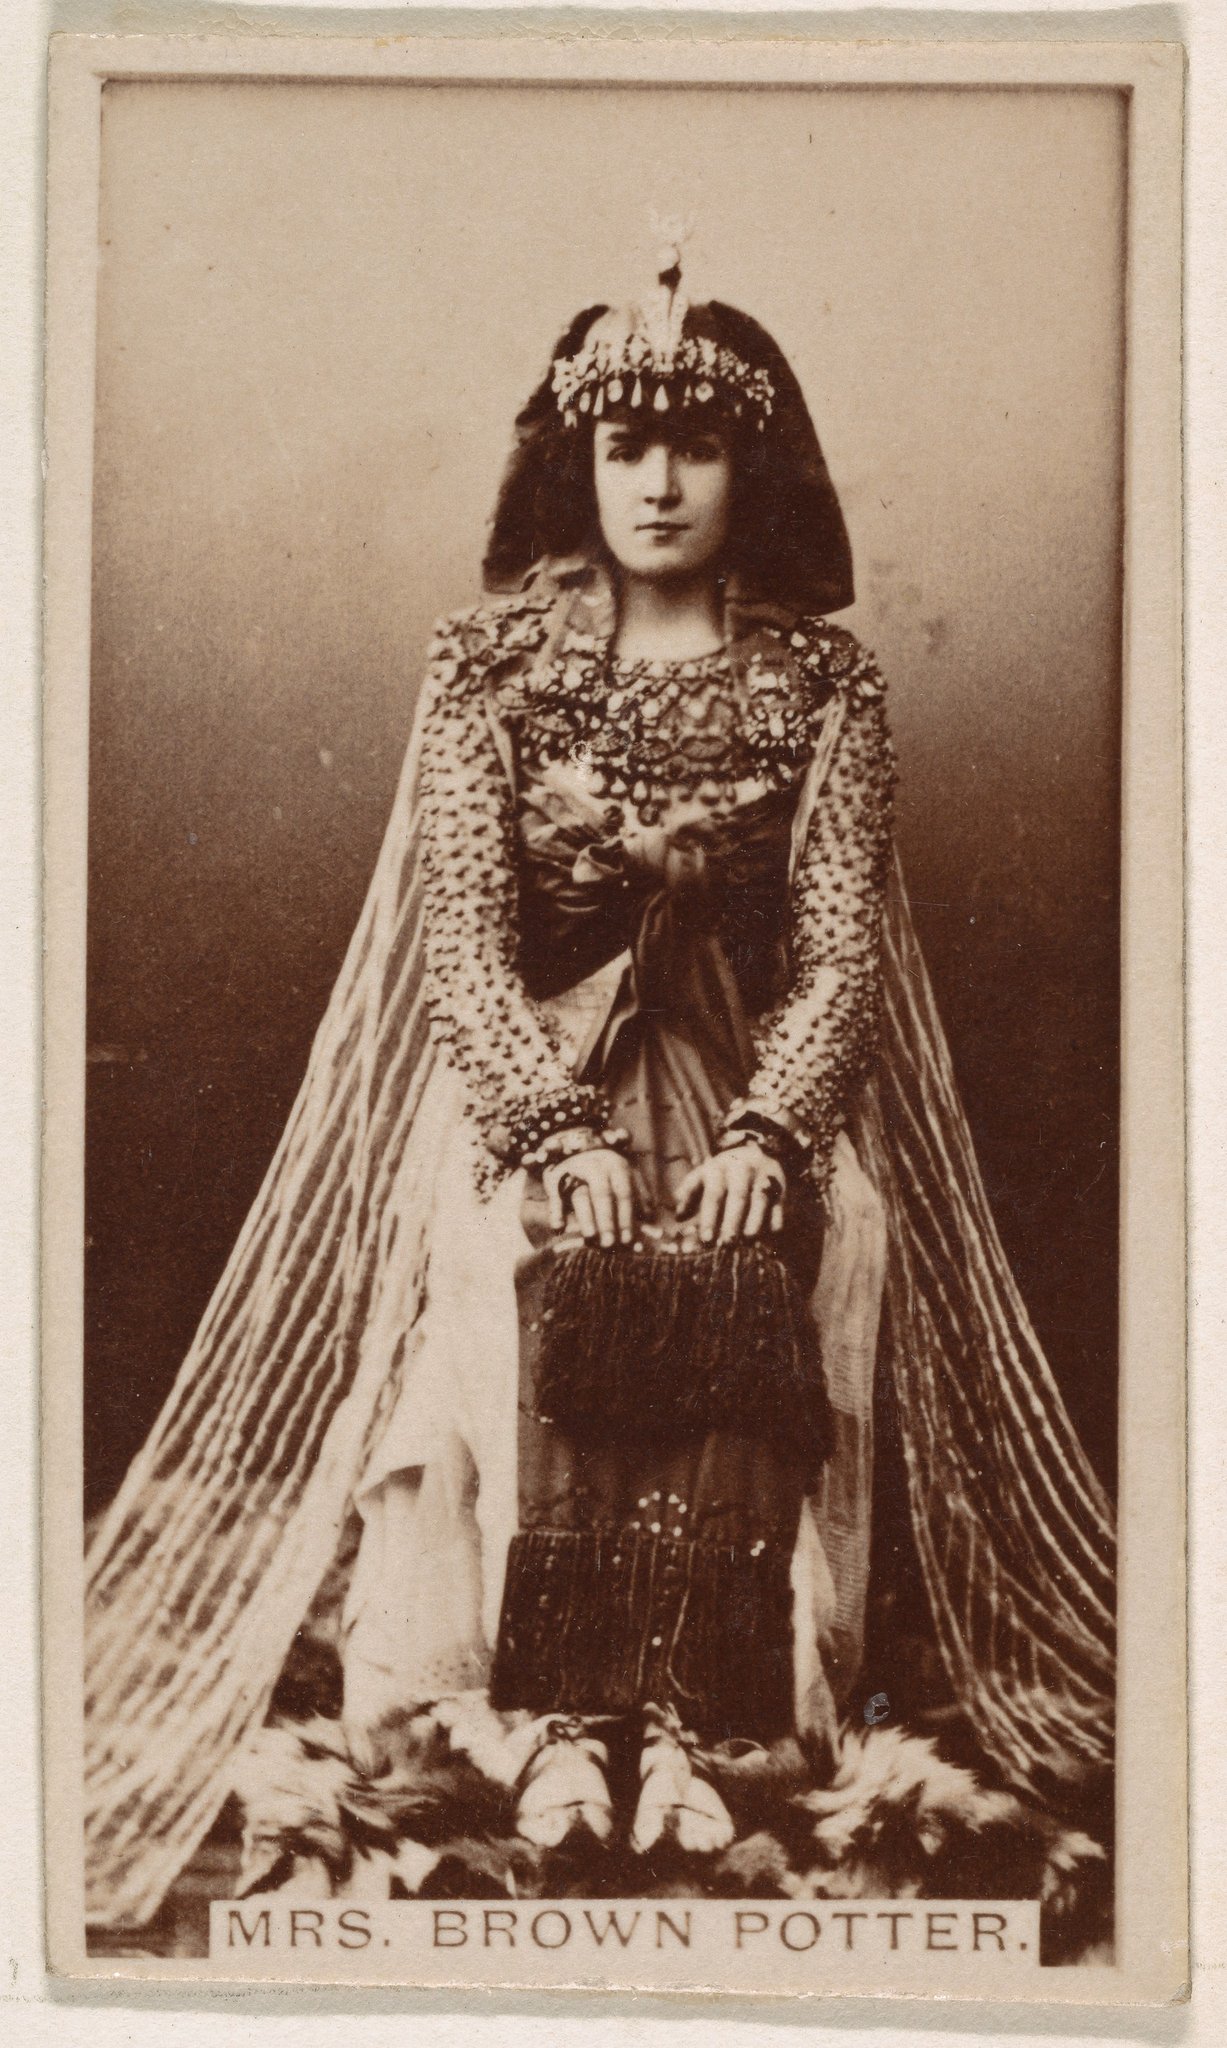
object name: photograph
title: Mrs. James Brown Potter, from the Actresses series (N245) issued by Kinney Brothers to promote Sweet Caporal Cigarettes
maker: kinney brothers tobacco company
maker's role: publisher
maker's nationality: american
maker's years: 1869-2011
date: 1890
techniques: albumen silver print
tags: portraits,women,actresses